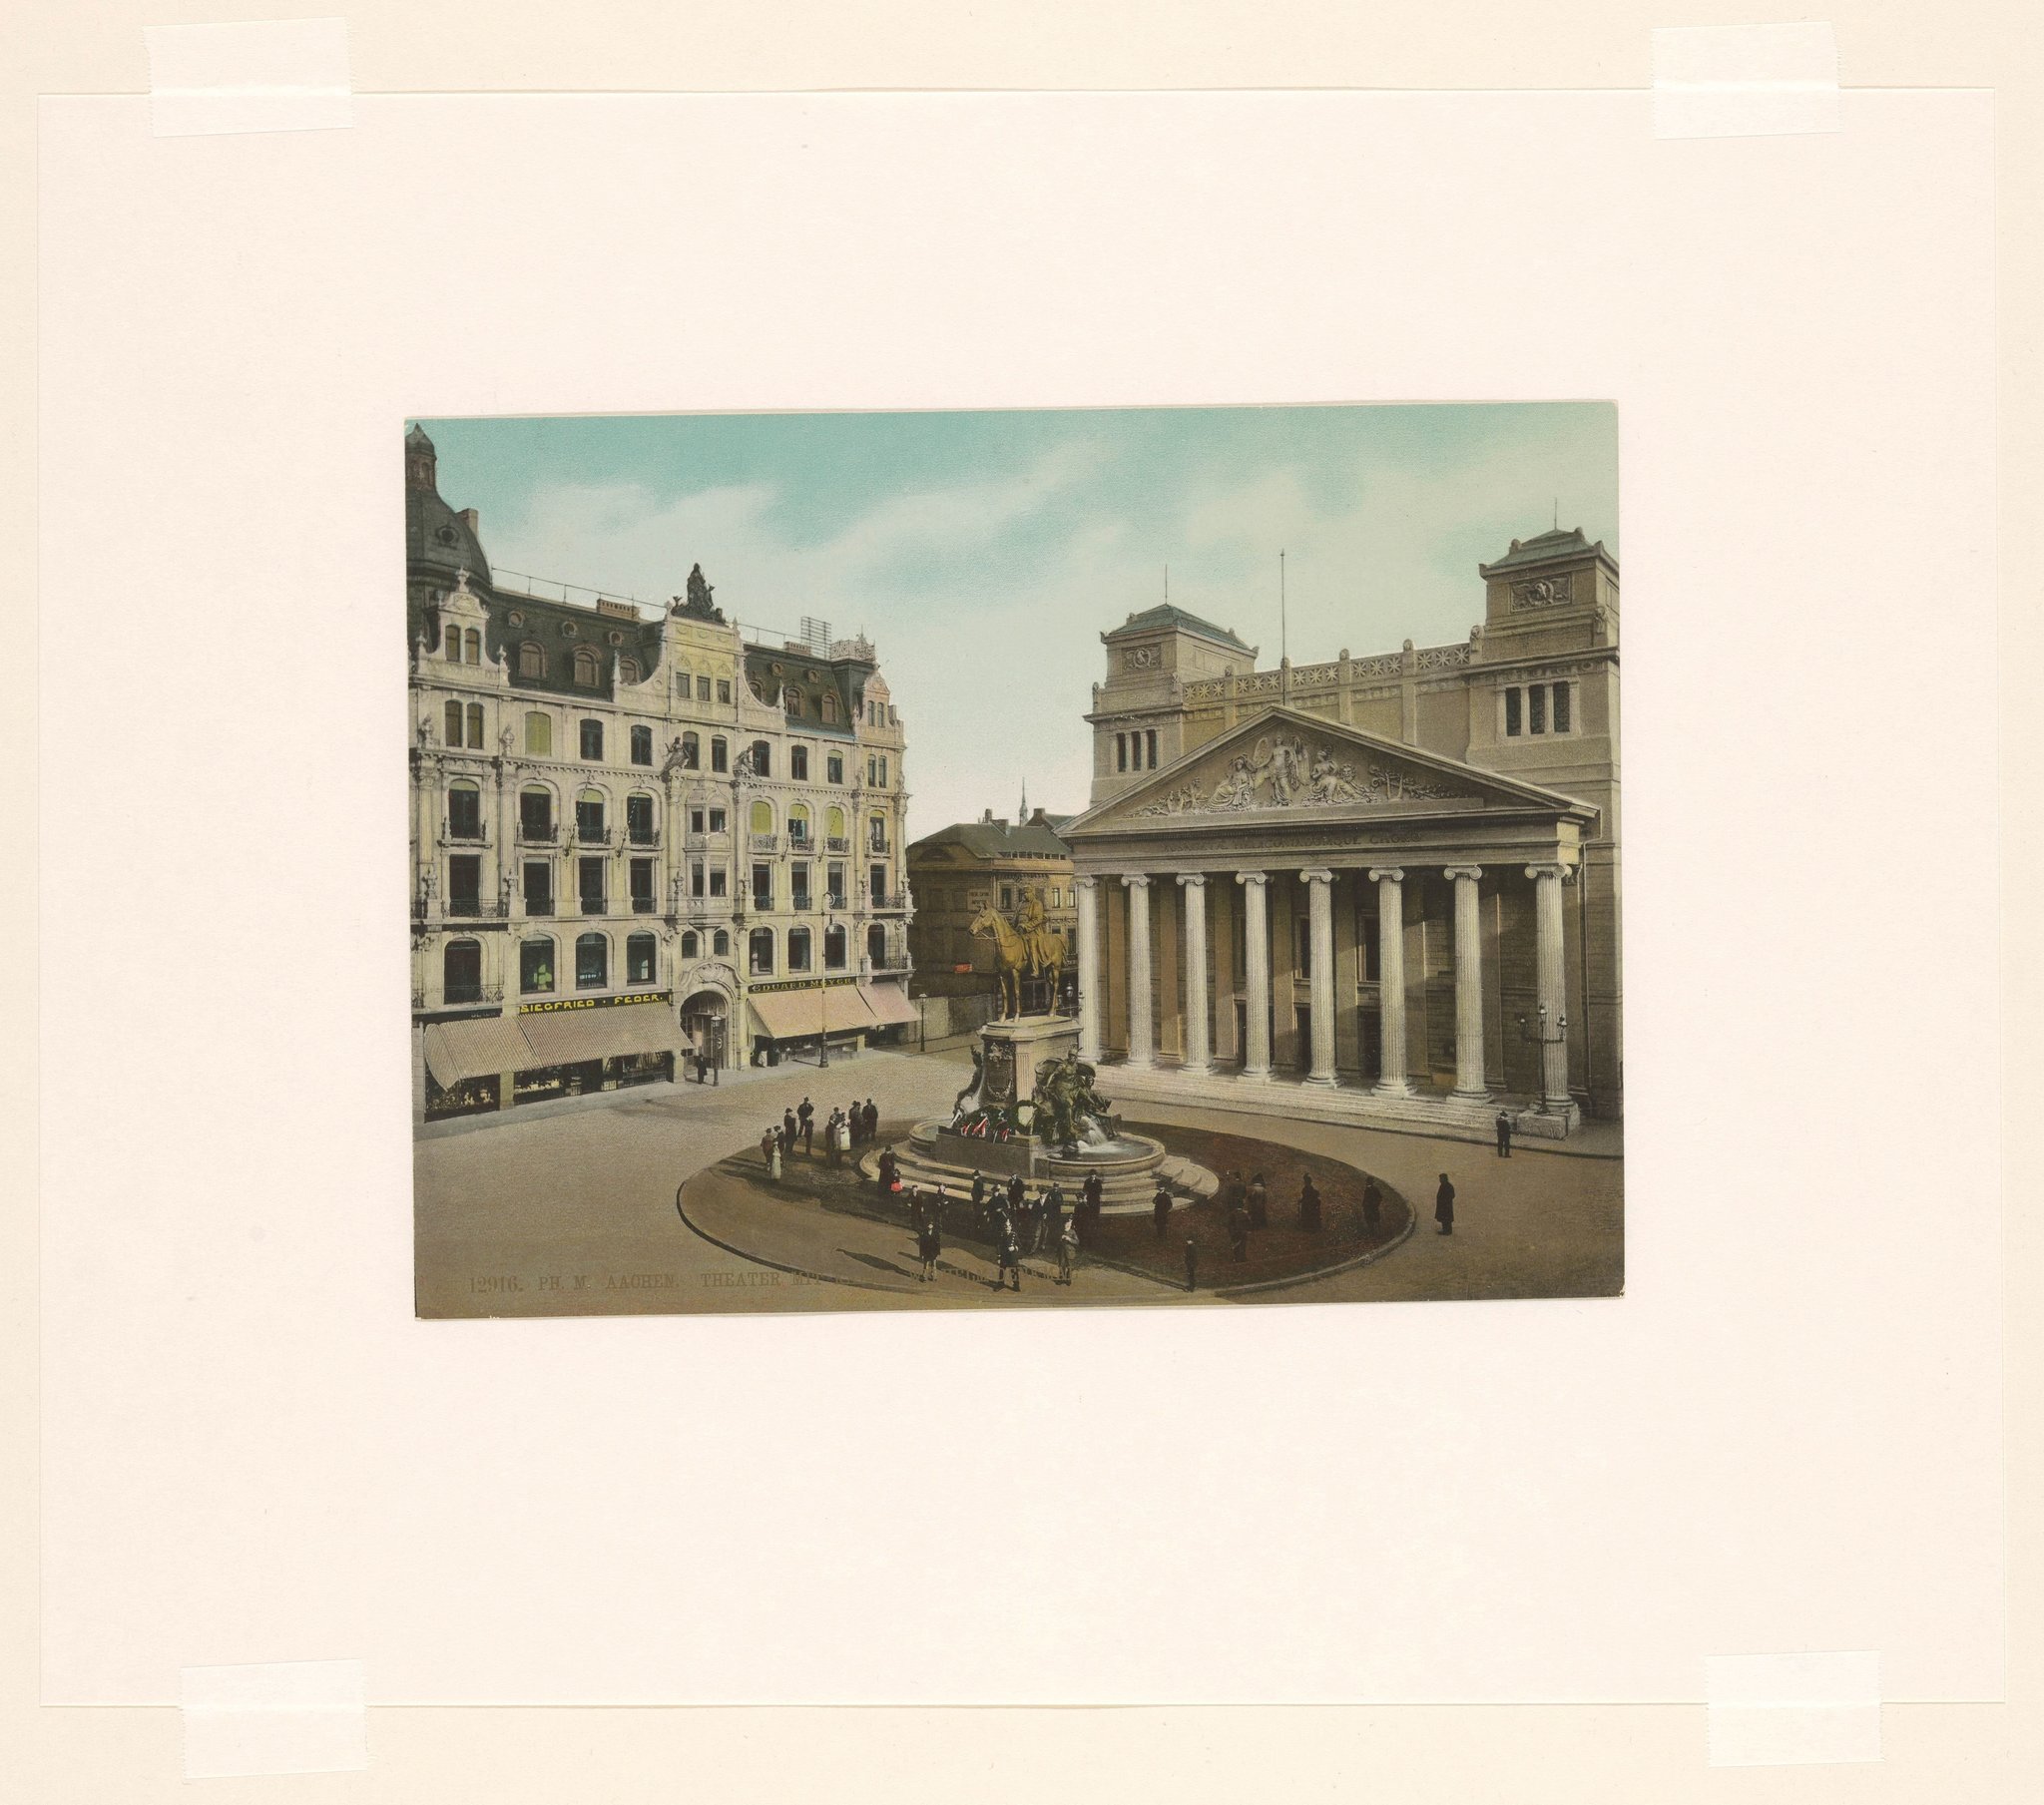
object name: photomechanical print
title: Aachen, Theater mit Kaiser Wilhelmdenkmal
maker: Anonymous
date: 1870-1930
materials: paper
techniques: photograph, lithograph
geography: aachen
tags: berlin, wilhelm i (keizer van duitsland), theatre (building), monument, statue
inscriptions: number: ‘12916. PH. M.’